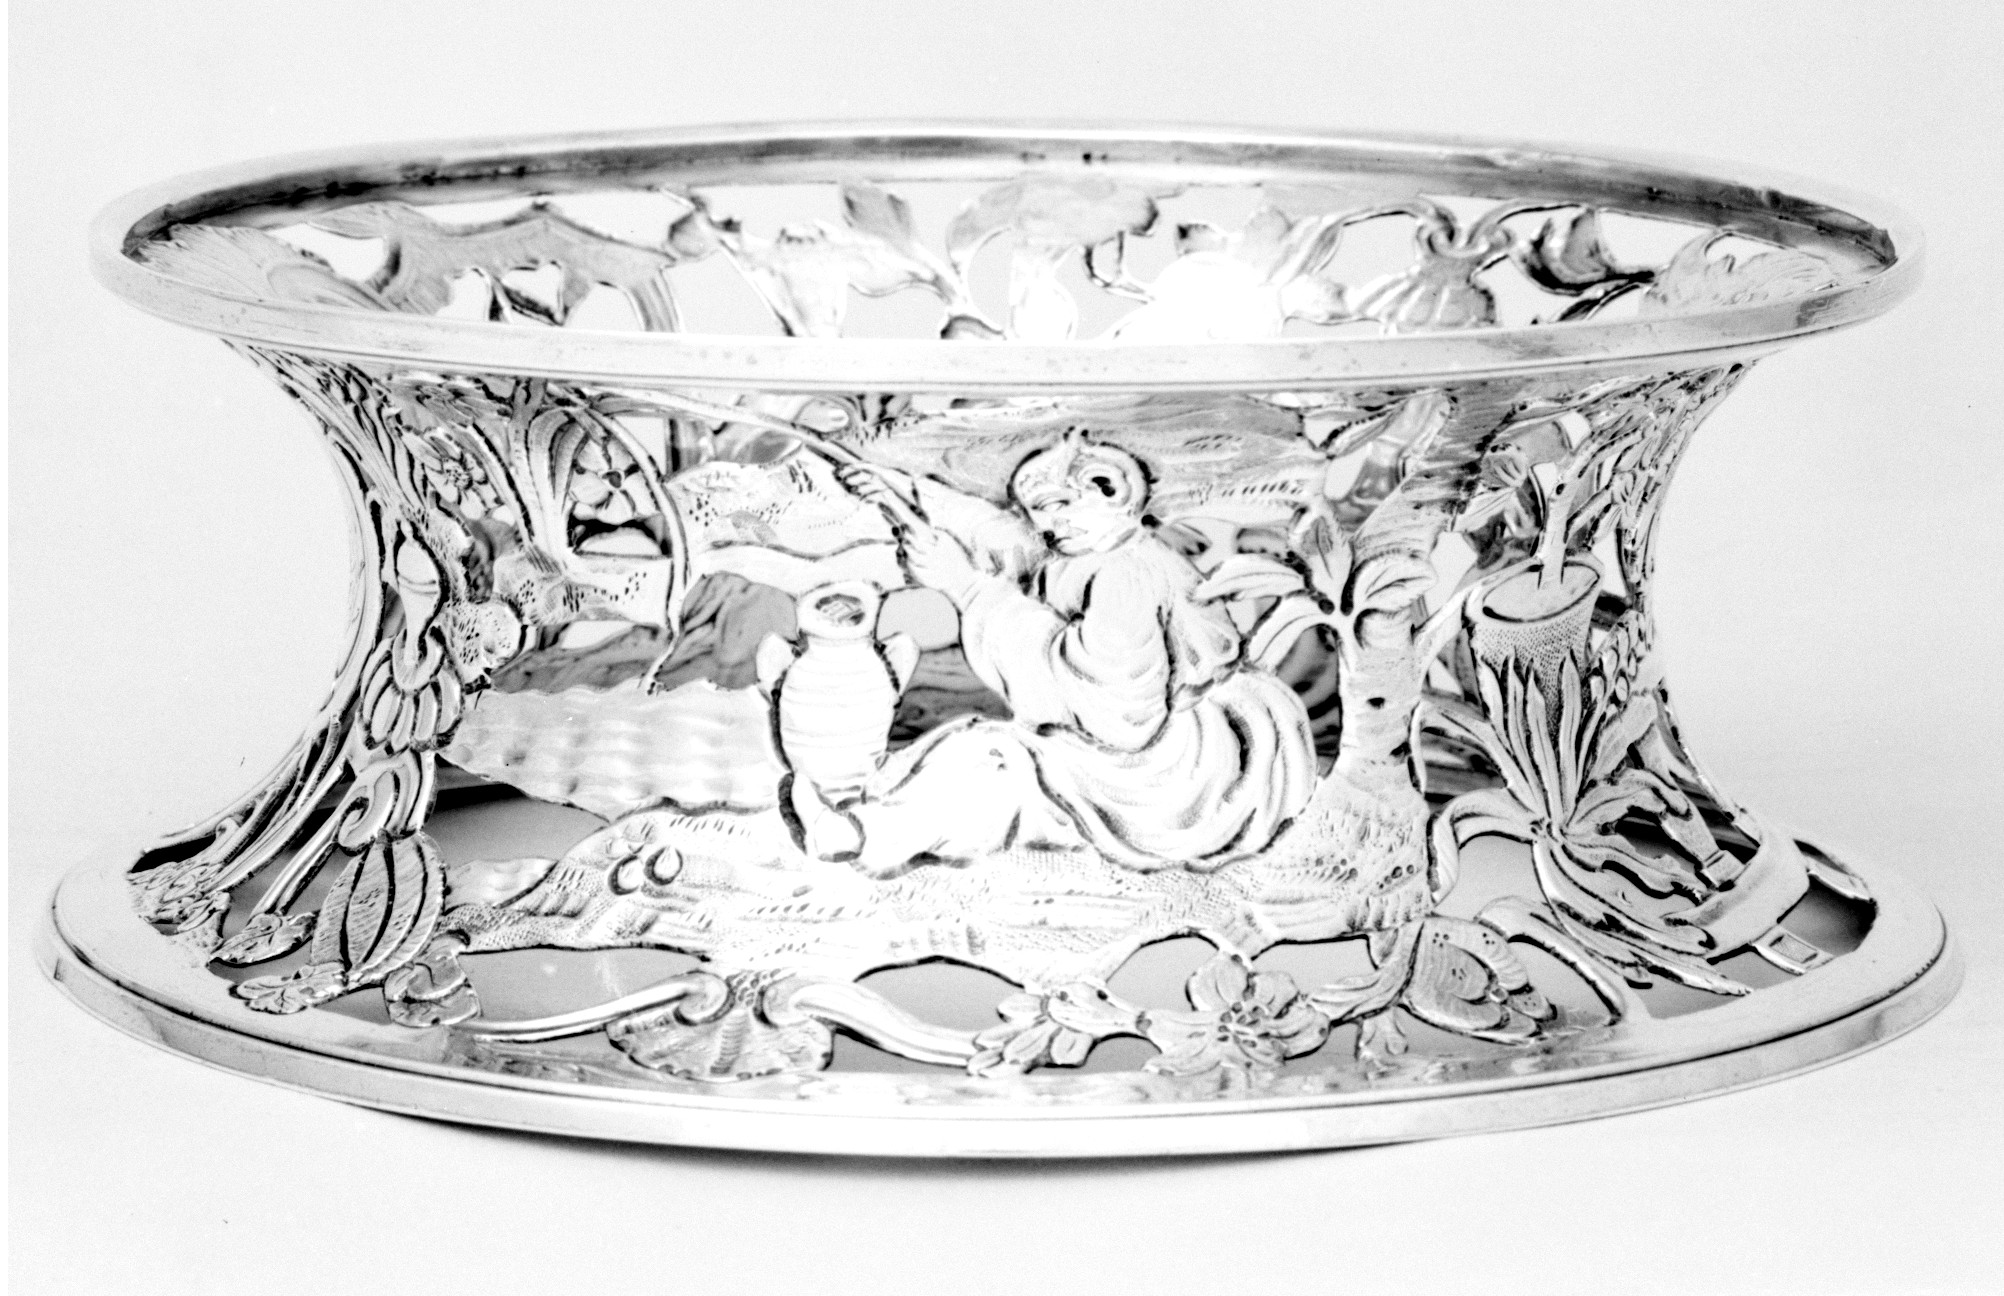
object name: dish ring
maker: christopher haines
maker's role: maker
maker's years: 1725-1825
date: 1770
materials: silver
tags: men,fishing,trees